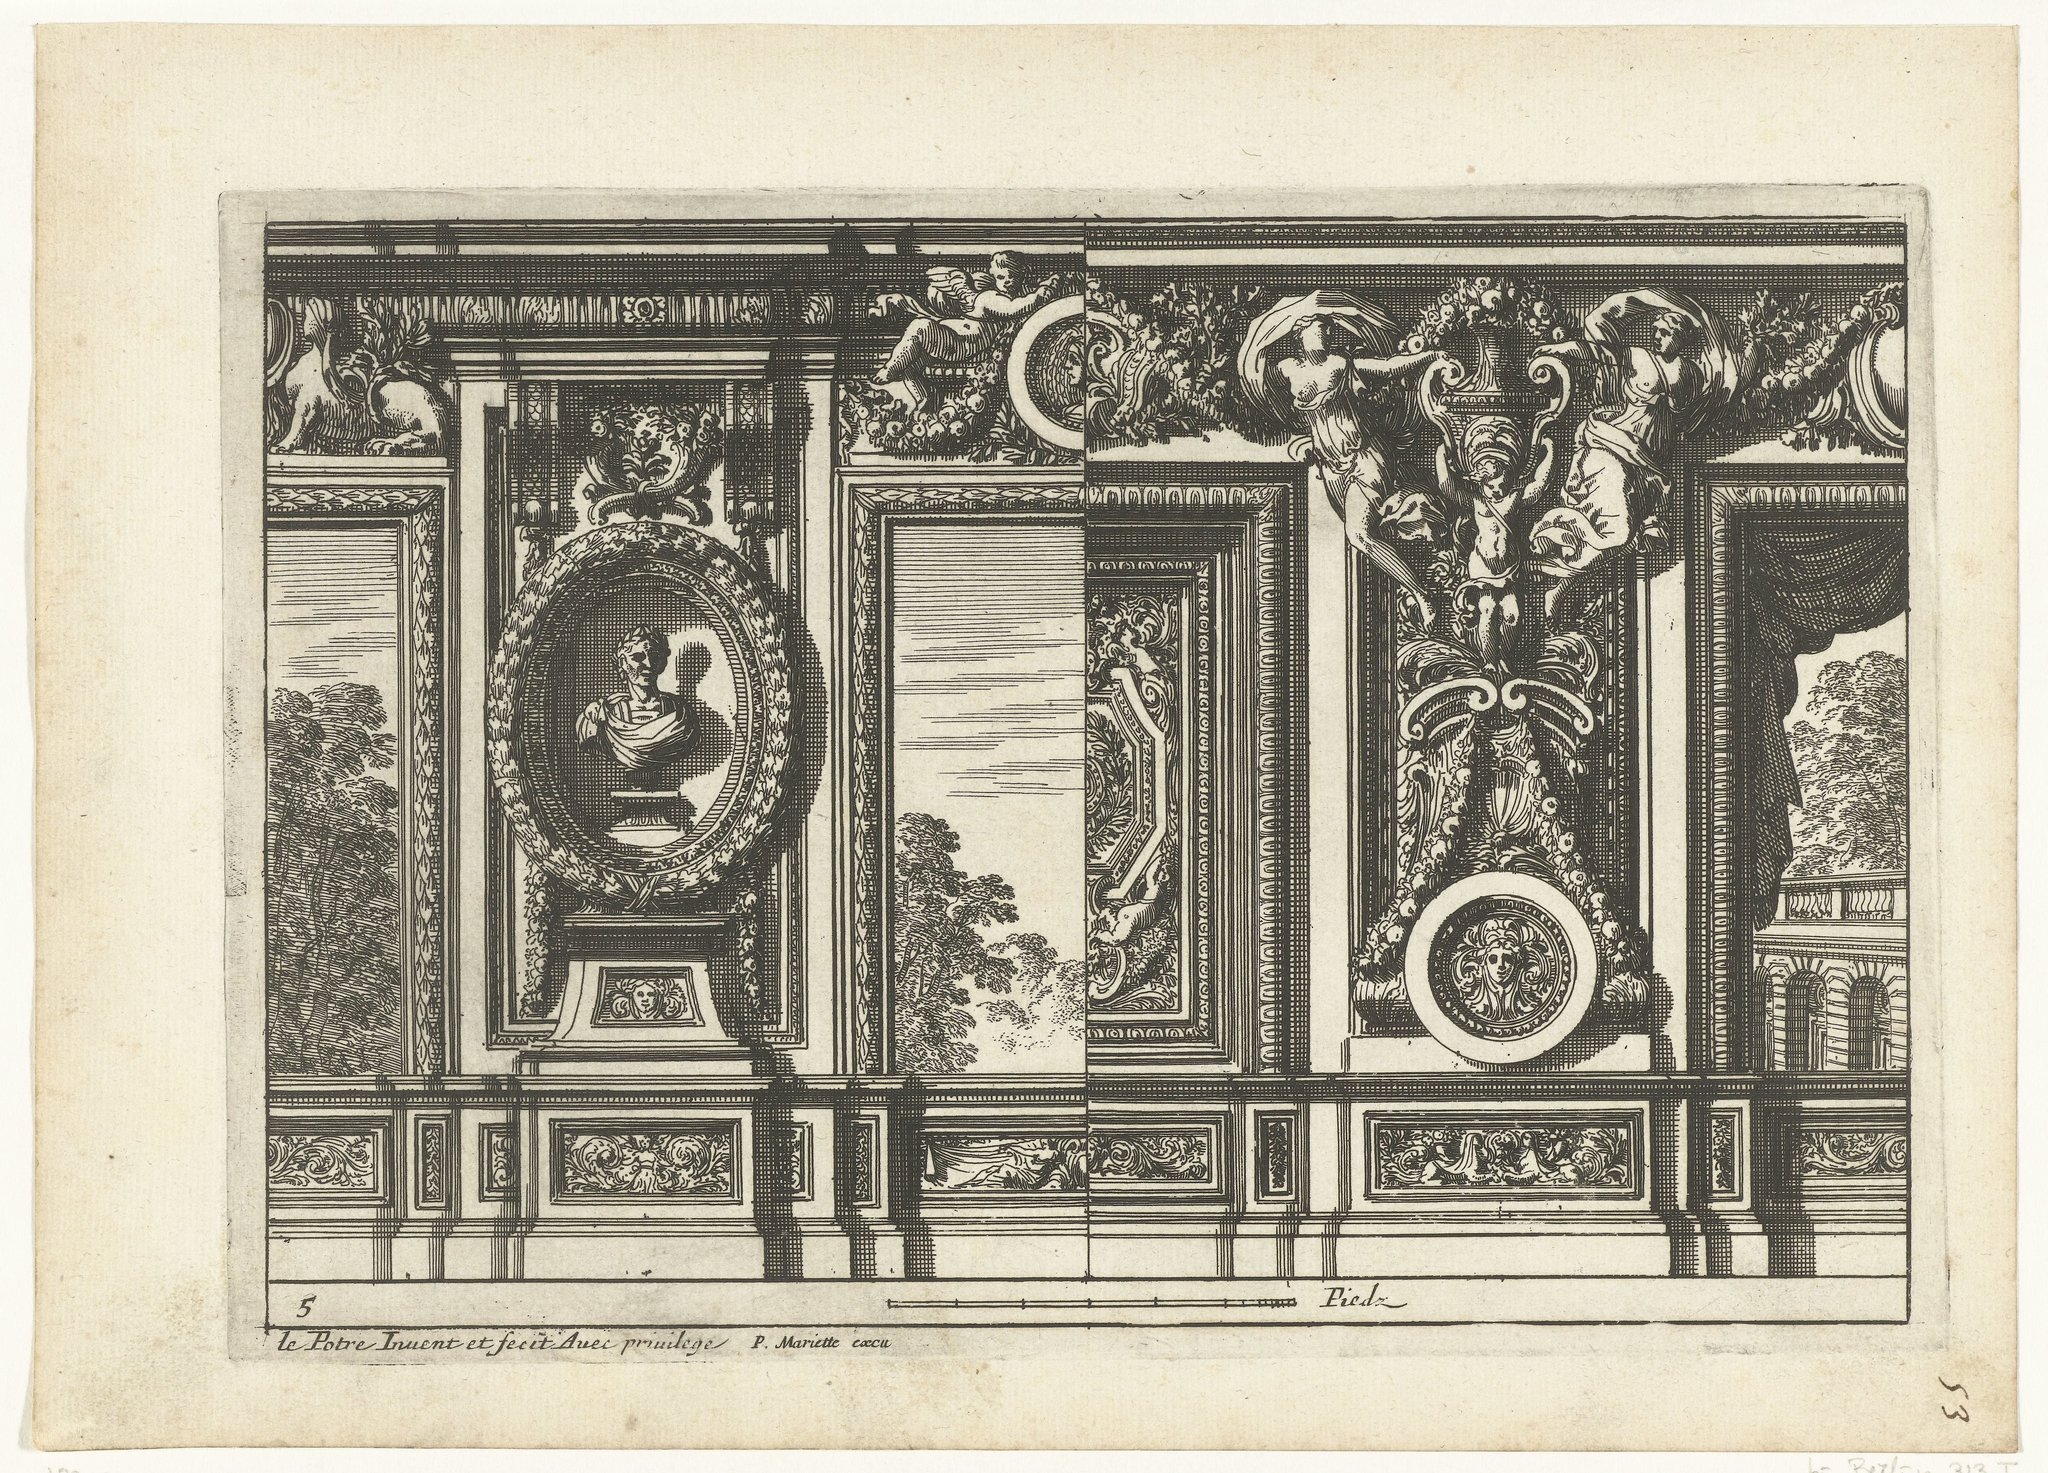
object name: ornament print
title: Lambris a la Romaine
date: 1661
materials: paper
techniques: etching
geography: france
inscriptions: number: ‘53’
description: Links staat een keizersbuste in een ovaal.